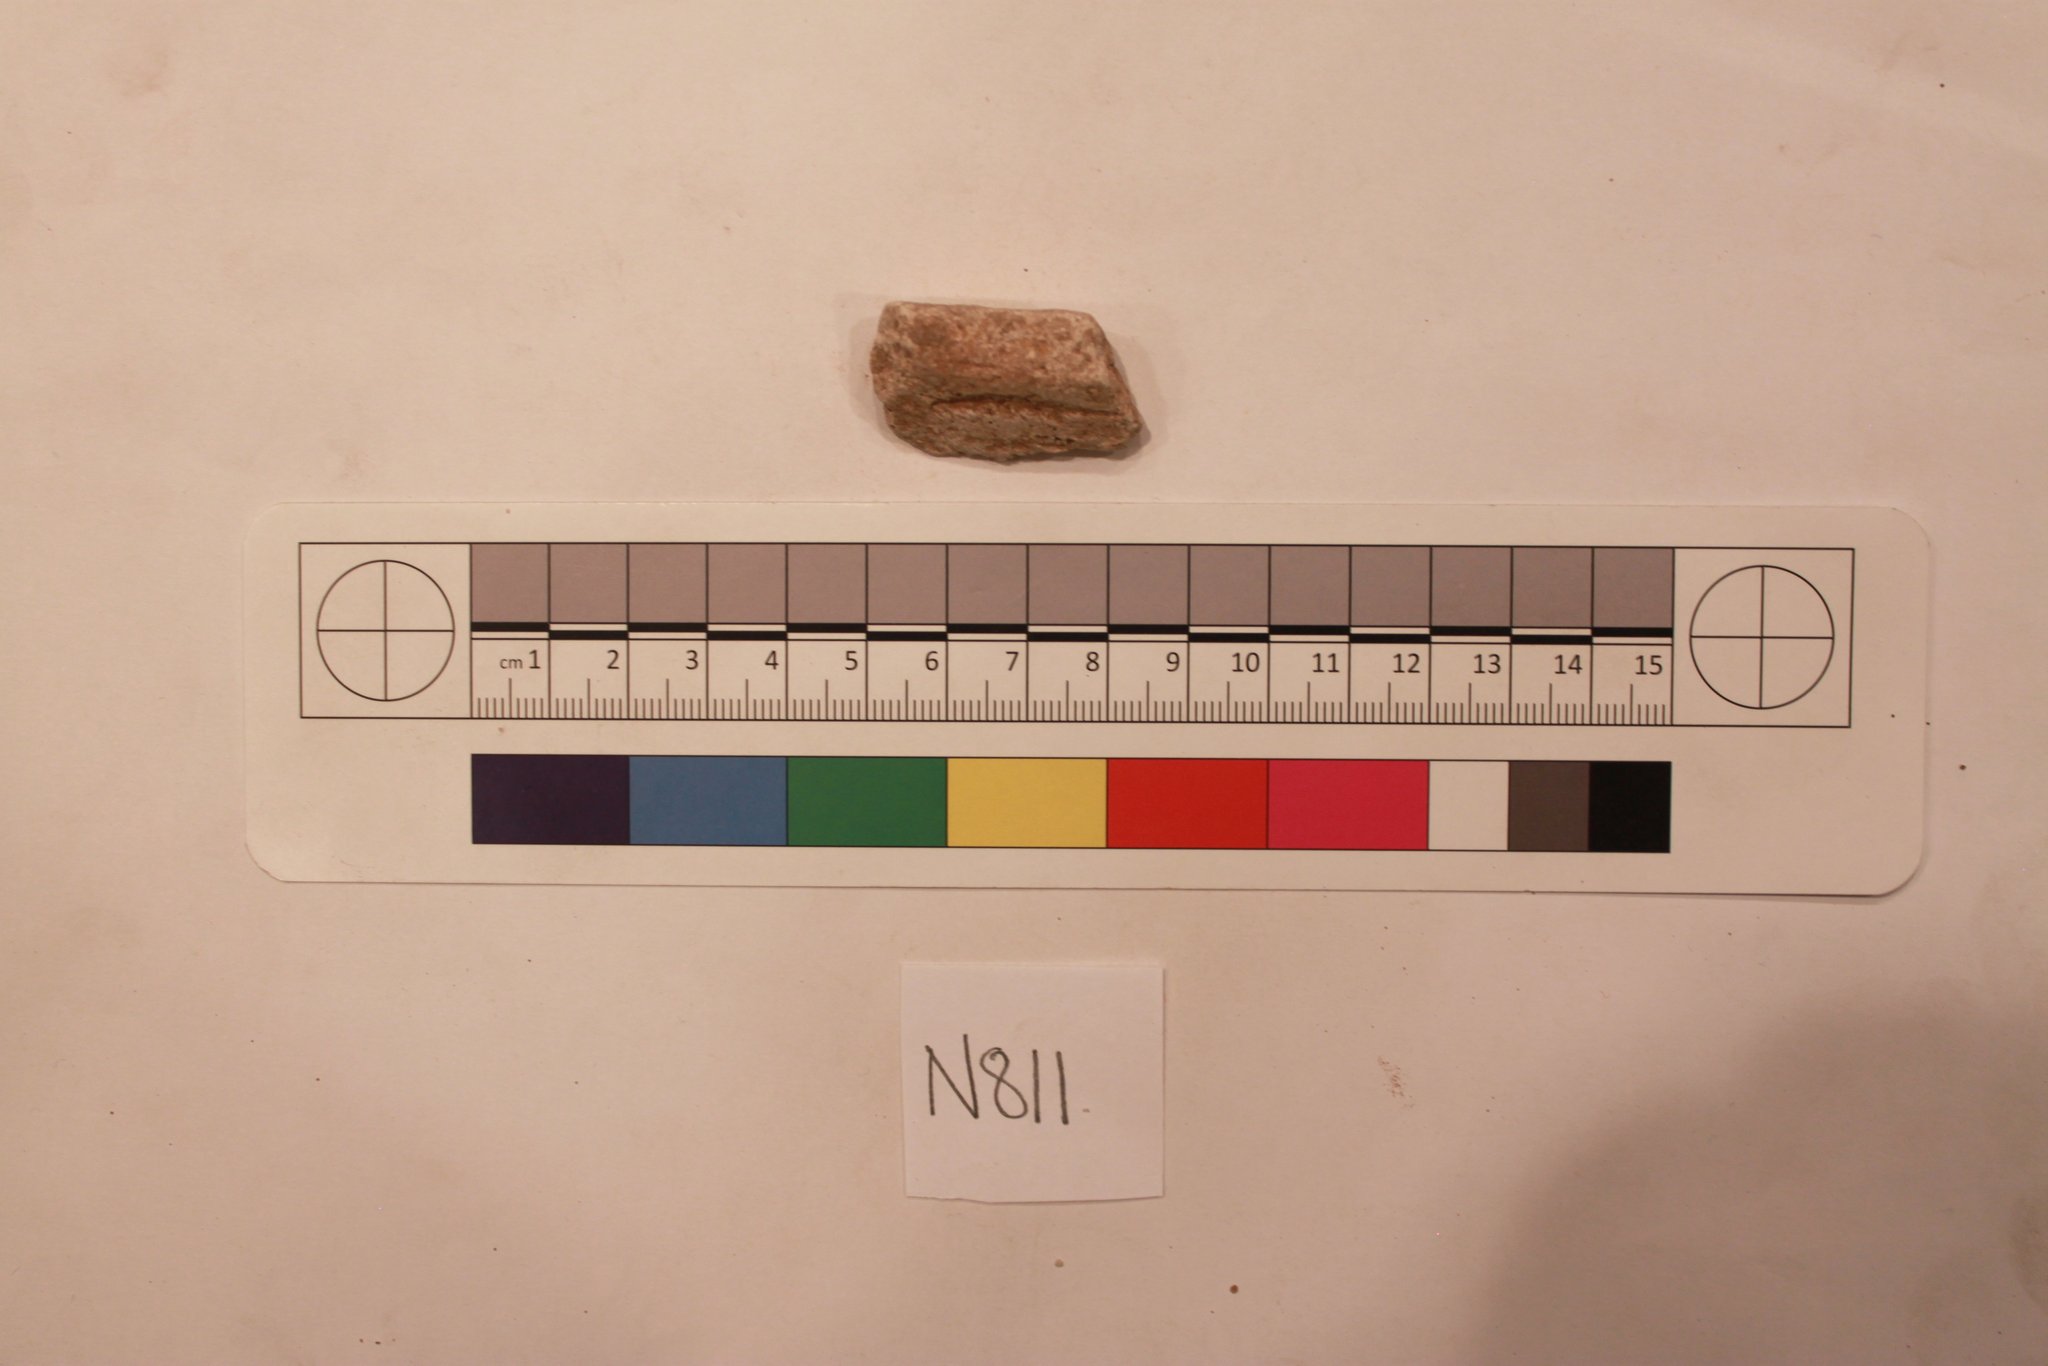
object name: fragment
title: Stucco Fragment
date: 701-1200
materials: plaster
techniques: carving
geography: iran